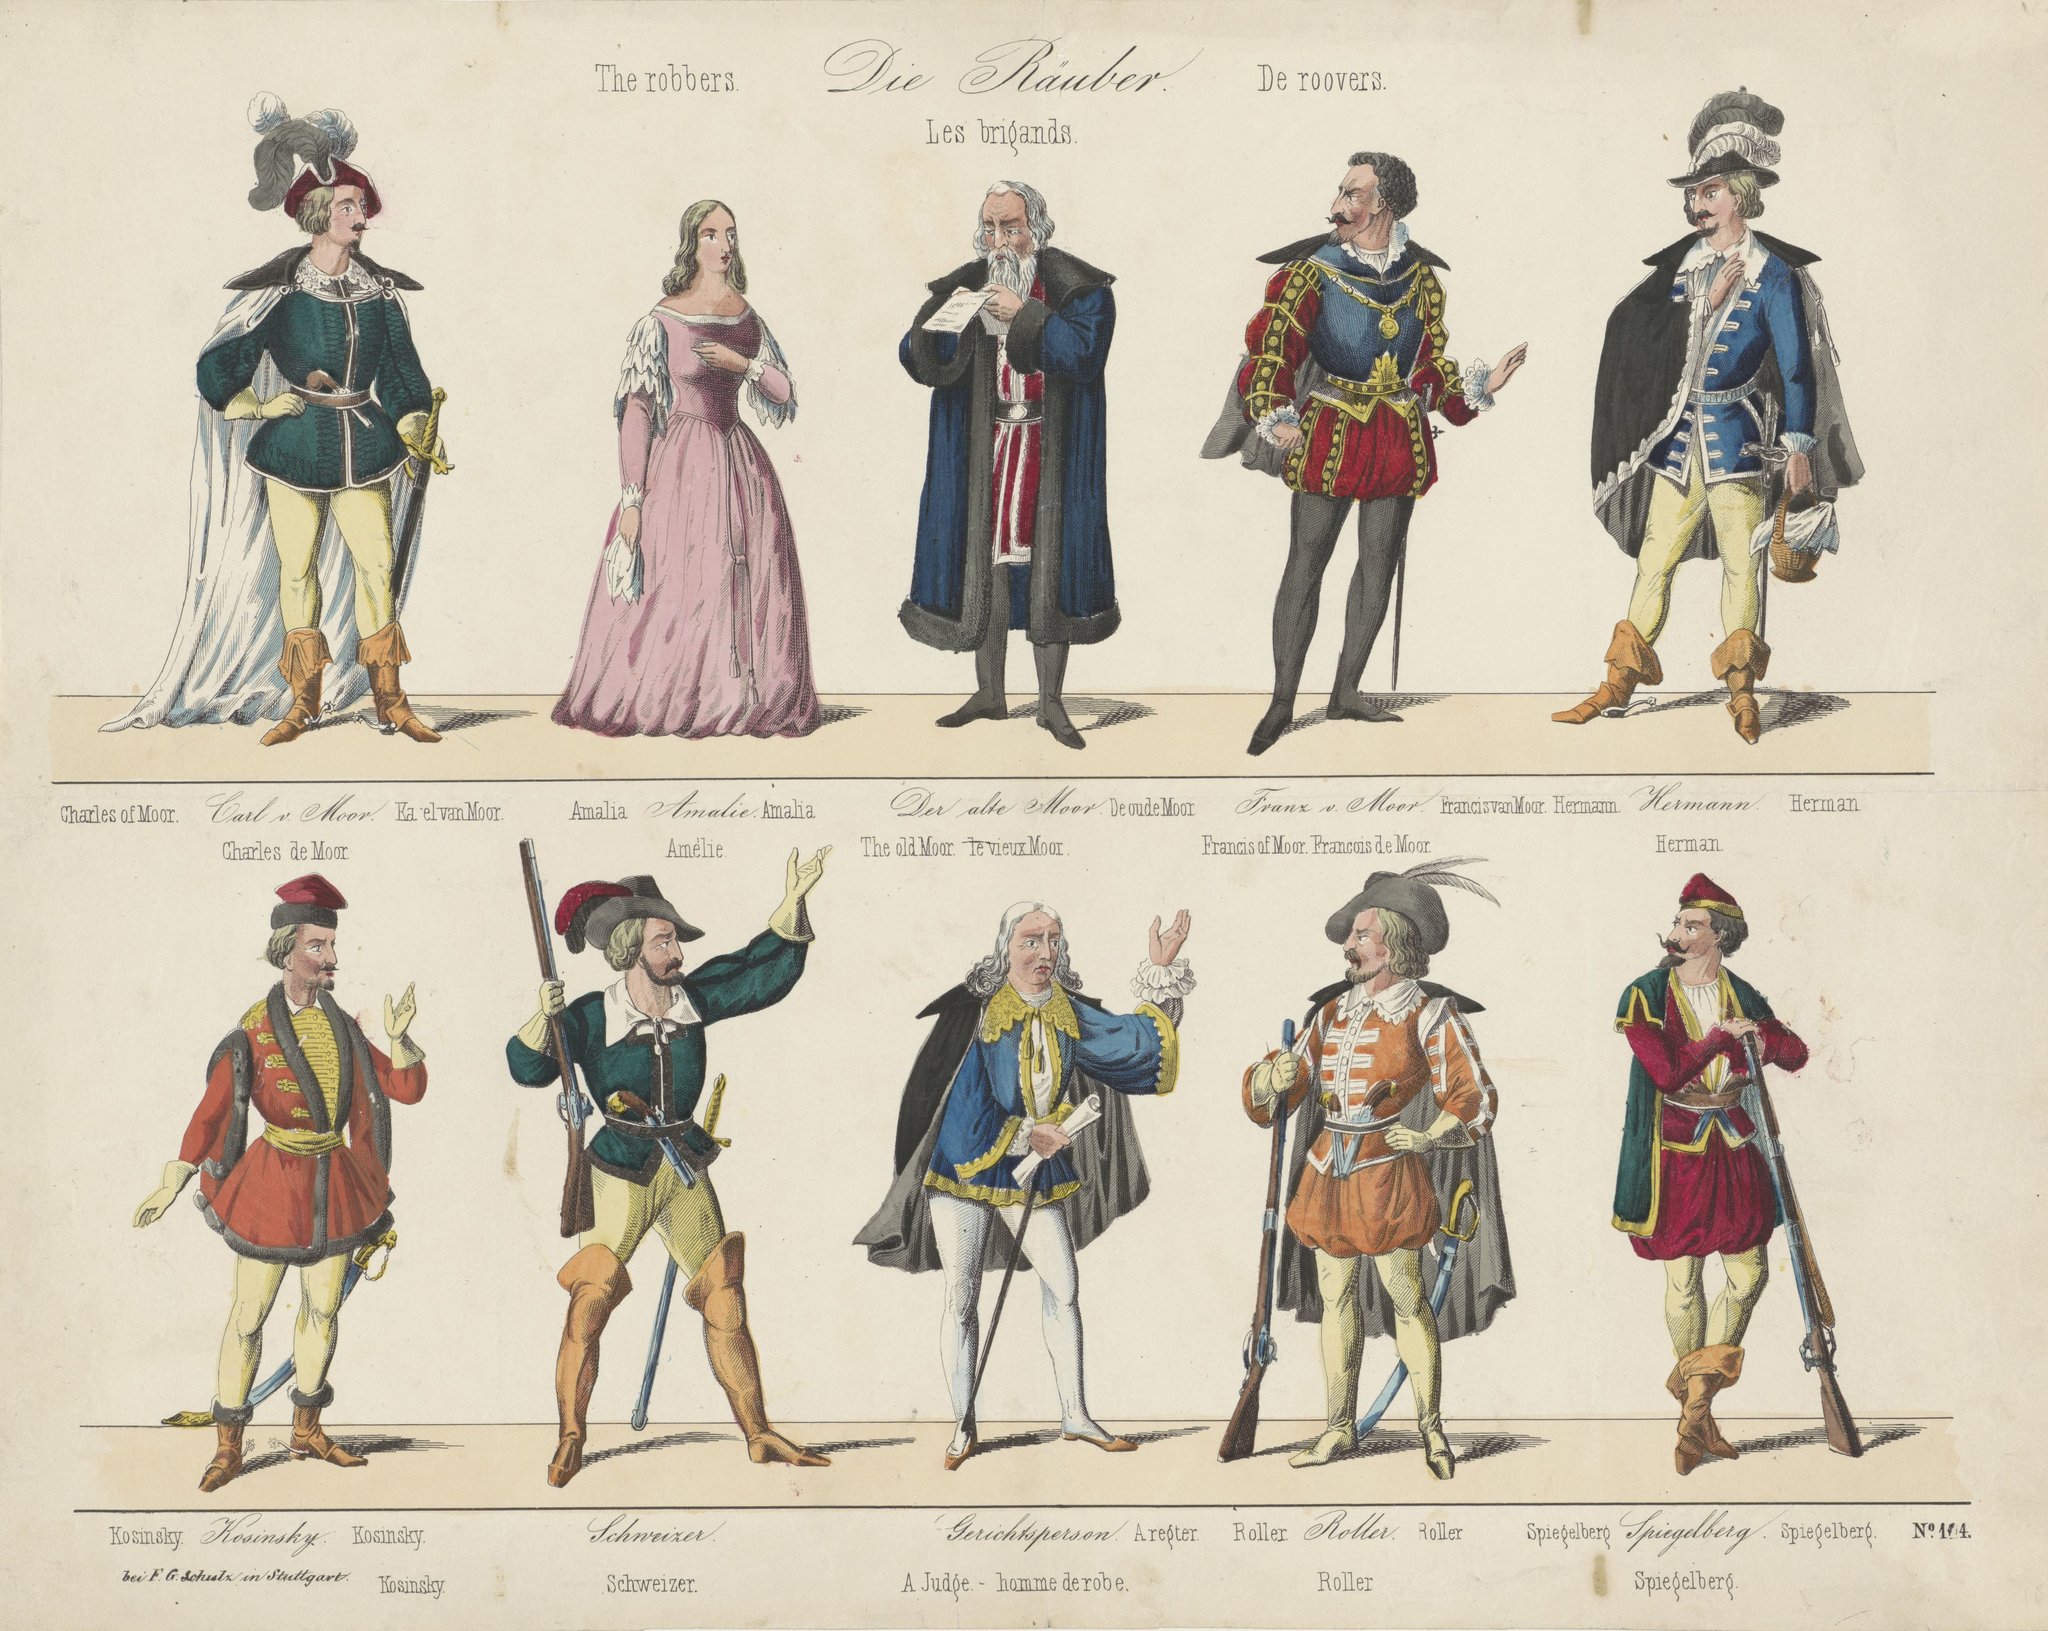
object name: print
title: The robbers. / Die Räuber. / De roovers. / Les brigands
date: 1820-1865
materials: paper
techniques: colour, lithograph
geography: europe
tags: stage costume, actor (on the stage), stage costume - cc - female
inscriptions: collector's mark: Lugt 2760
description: Blad met 2 horizontale rijen met voorstellingen van personages uit het toneelstuk "De roovers" door Friedrich Schiller uit 1782, over het conflict tussen de twee broers Karel en Frans de Moor. Onder elk personage zijn of haar naam in het Engels, Duits, Nederlands en Frans. Genummerd rechtsonder: No. 104.